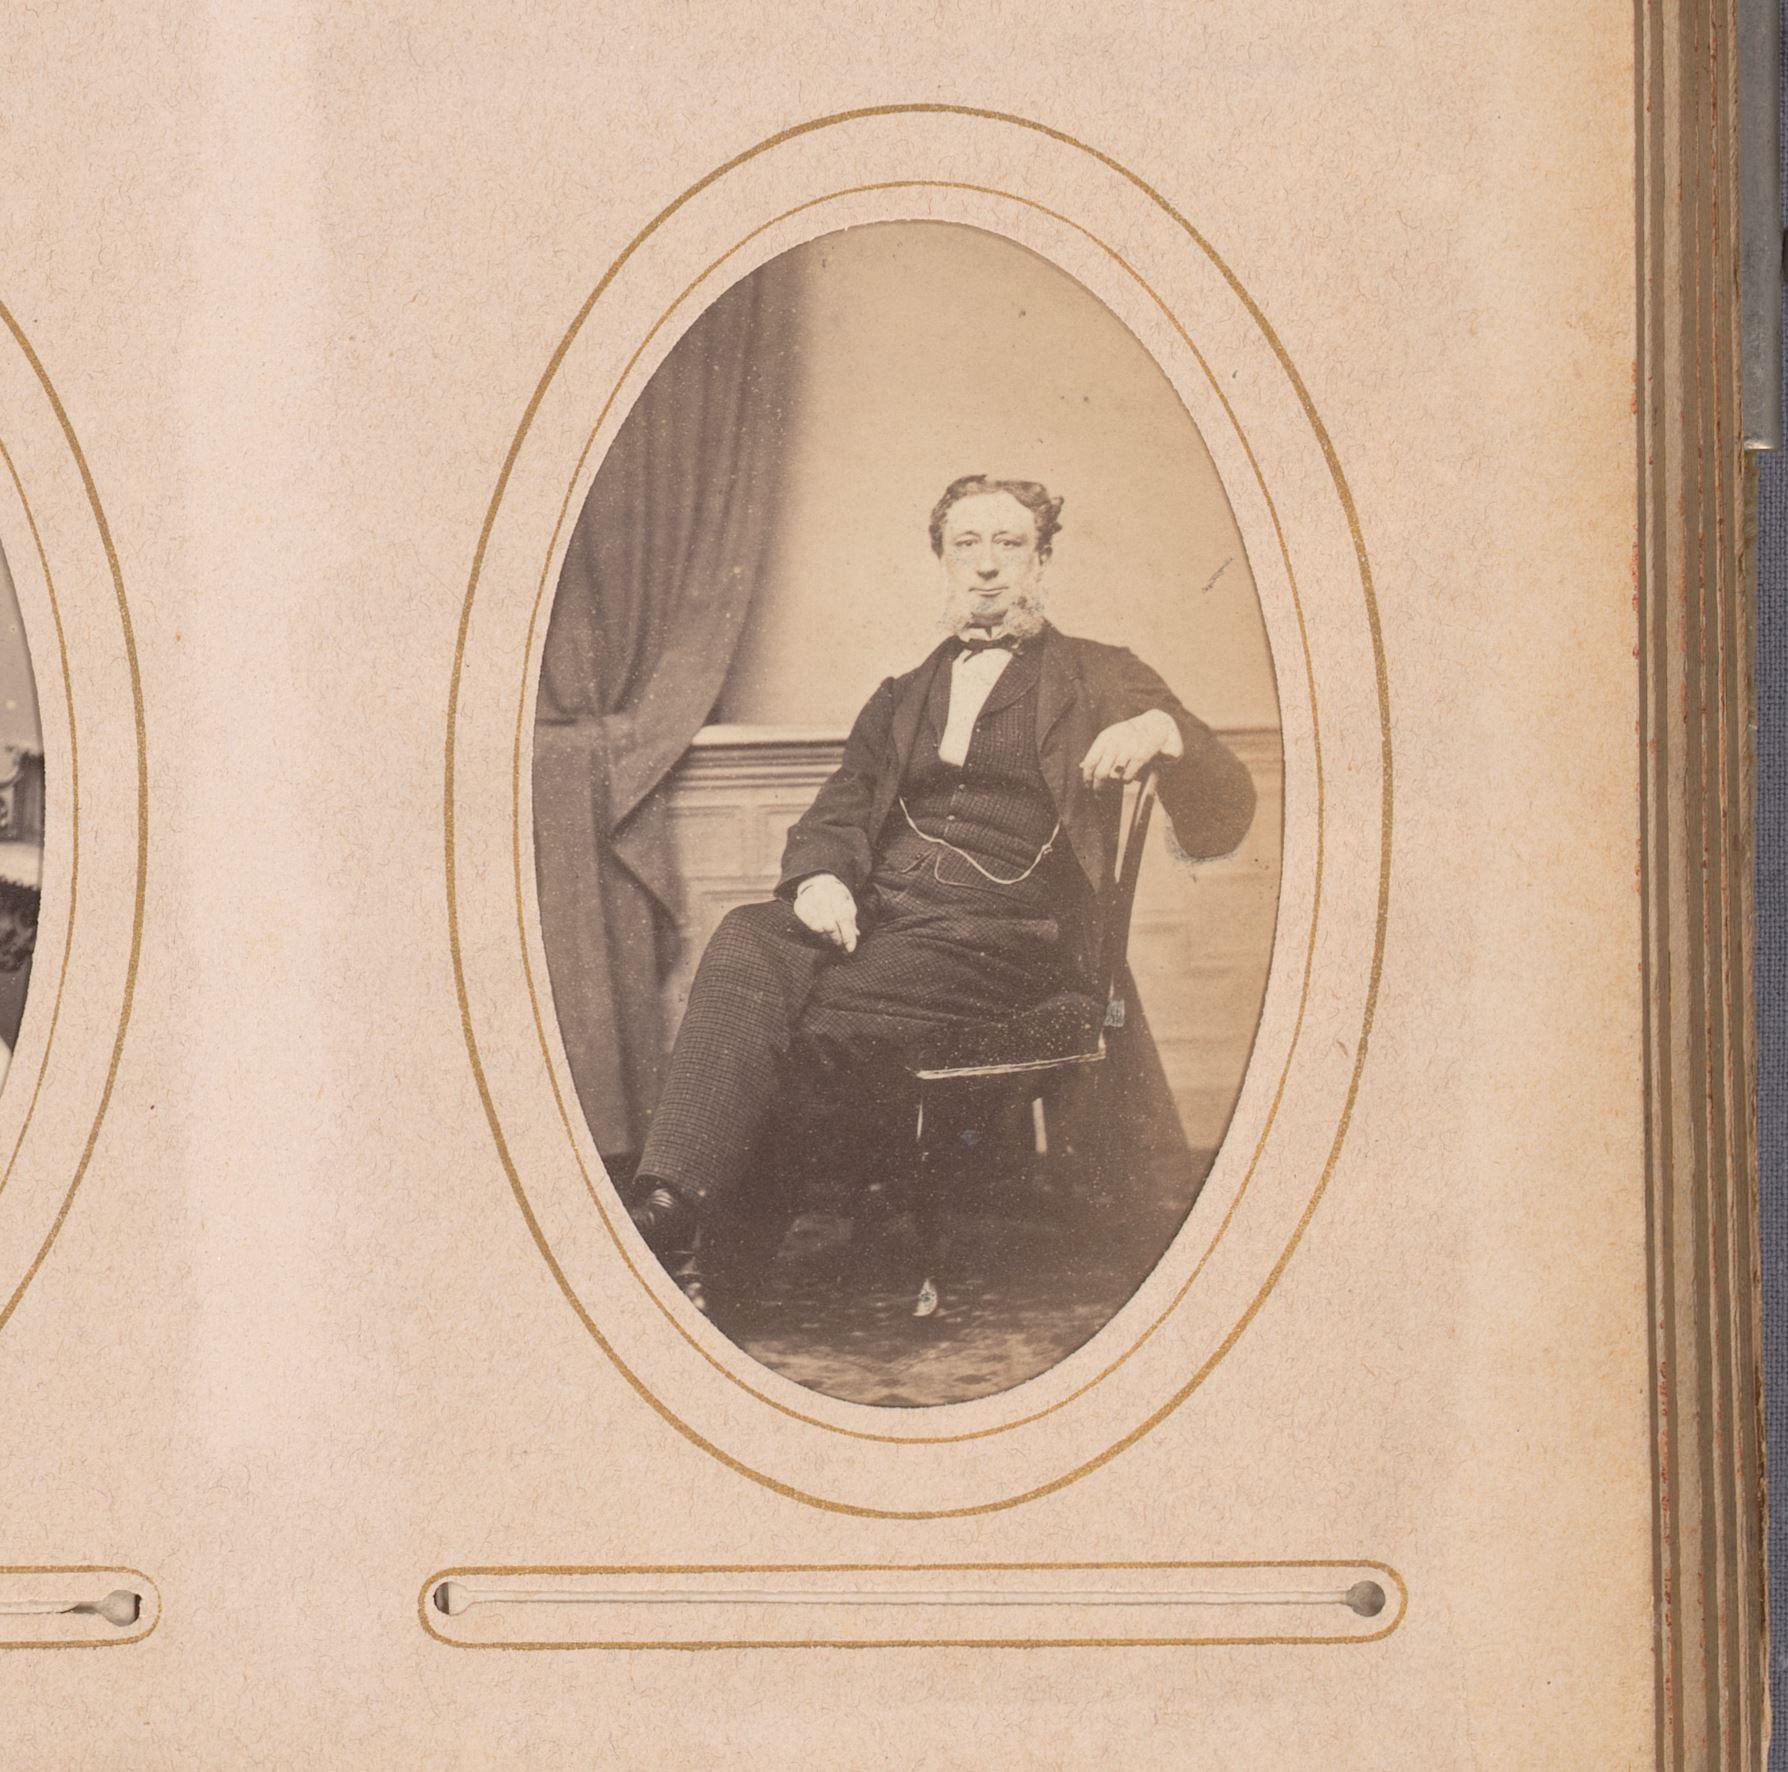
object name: album leaf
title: Portret van een zittende man met bakkebaarden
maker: eduard françois georges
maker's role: sculptor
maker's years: 1817-1895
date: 1863-1890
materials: cardboard, photographic support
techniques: albumen print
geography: utrecht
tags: sideburns, sitting figure, historical persons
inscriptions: inscription: ‘Georges/ Statuaire/ Photographe/ Utrecht/ Vrouw Jutte straat/ 344’